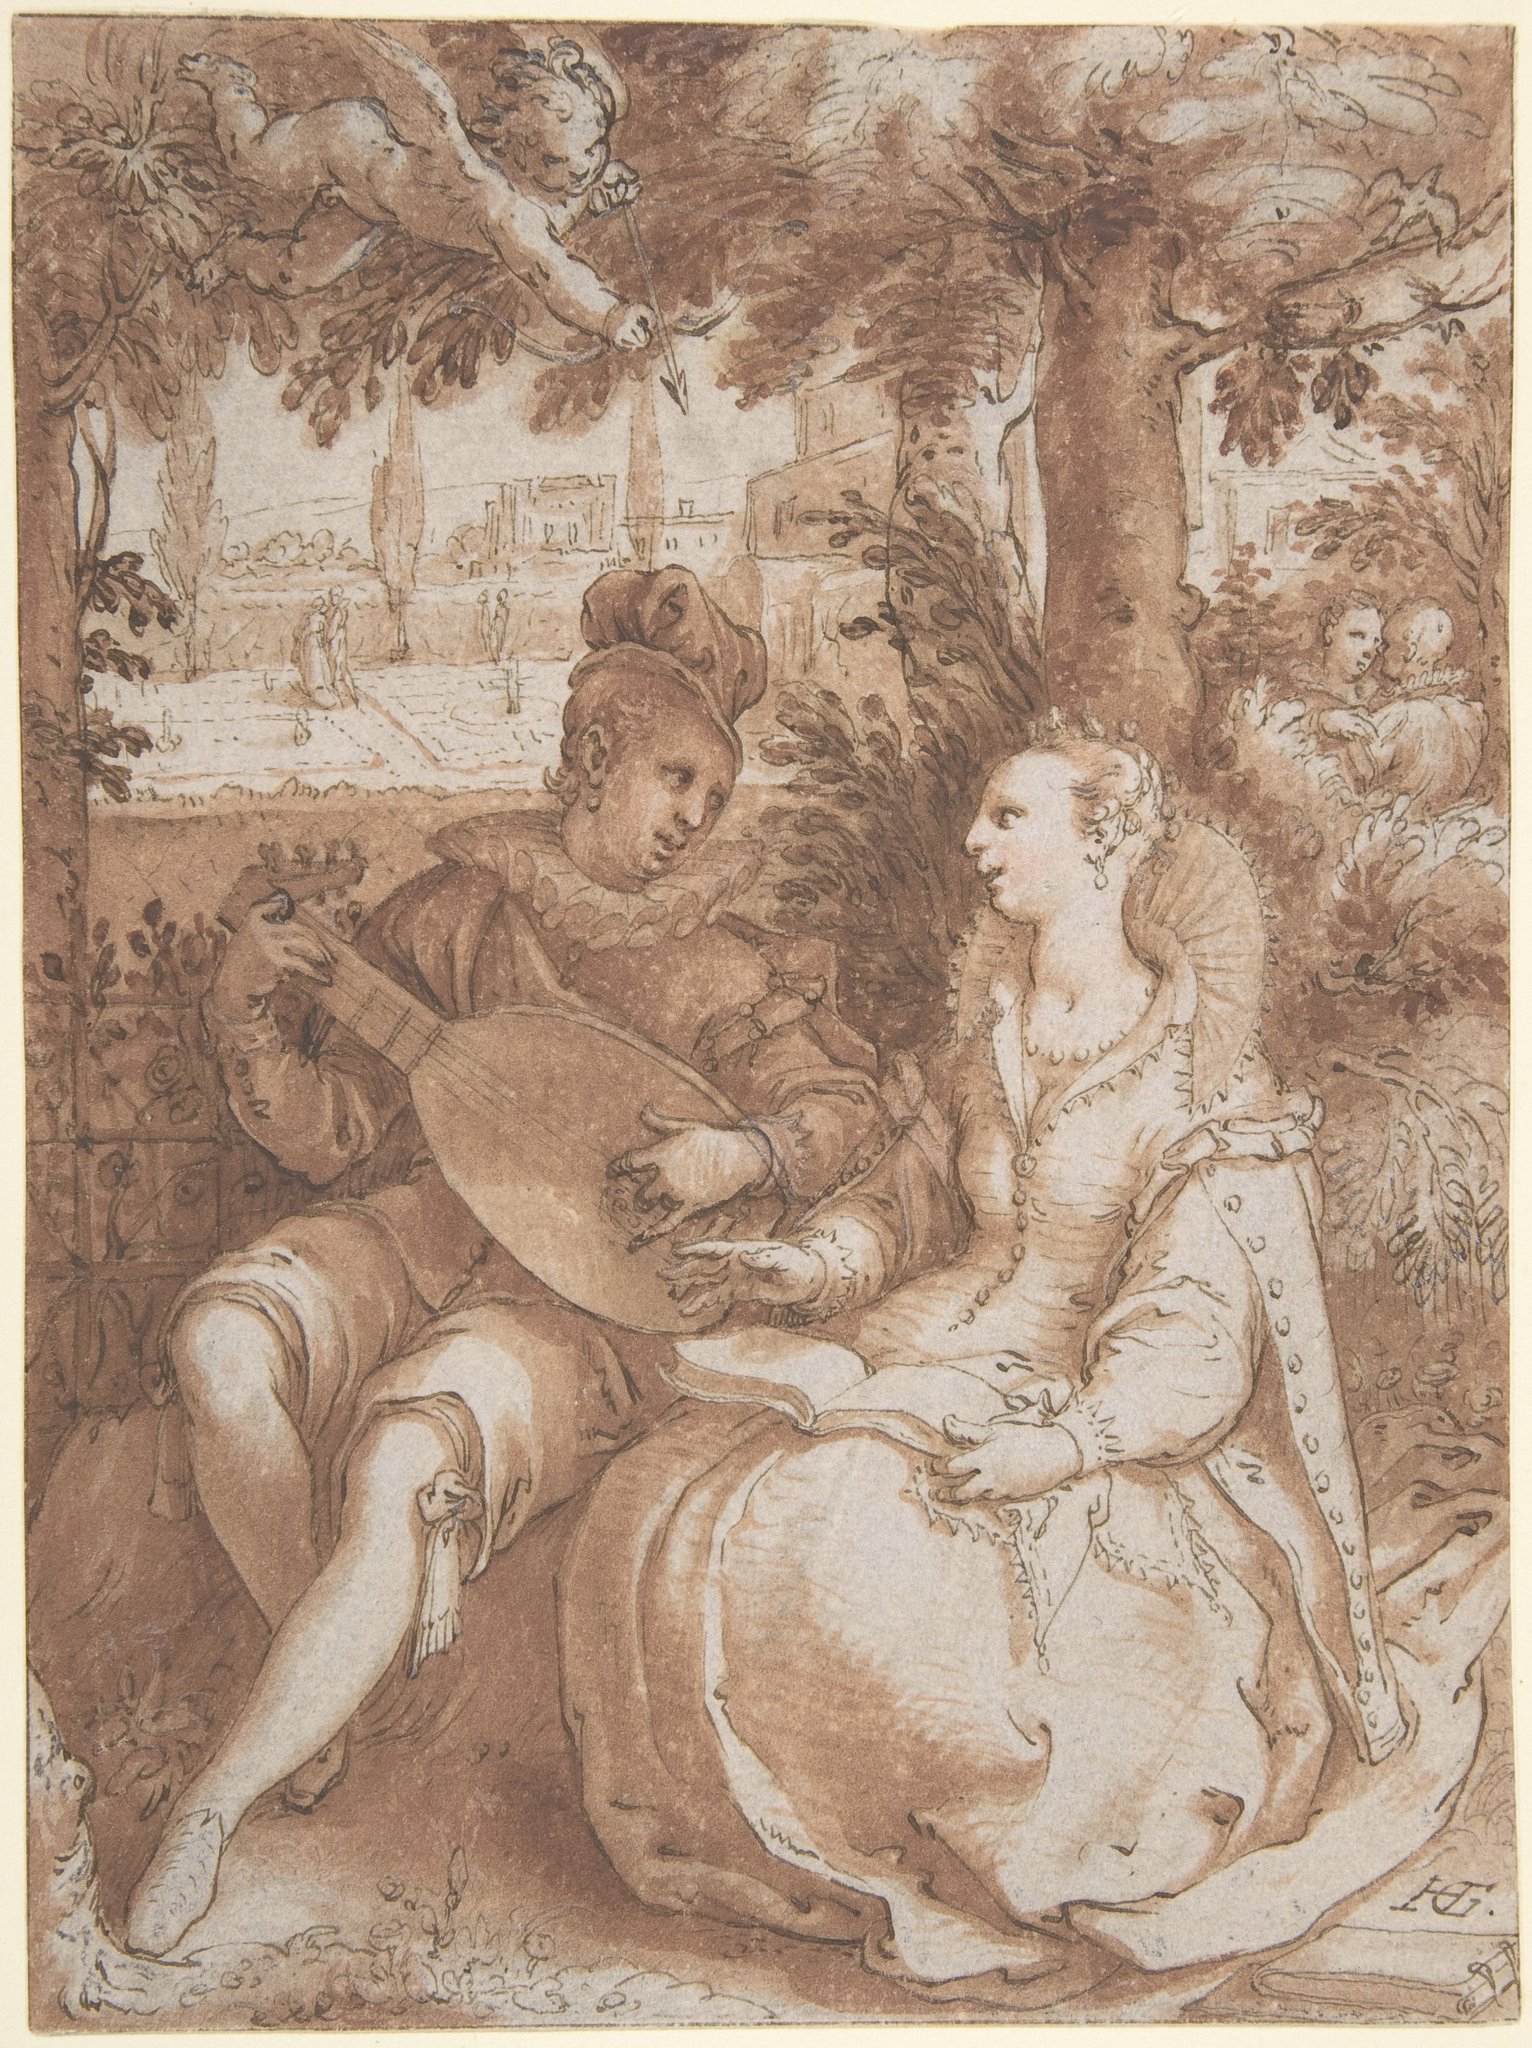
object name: drawing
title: Spring, Drawing for Engraving of the Same Subject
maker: hendrick goltzius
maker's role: artist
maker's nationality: netherlandish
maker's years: 1558-1617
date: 1594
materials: ink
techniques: brush, pen, wash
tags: couples,men,women,lutes